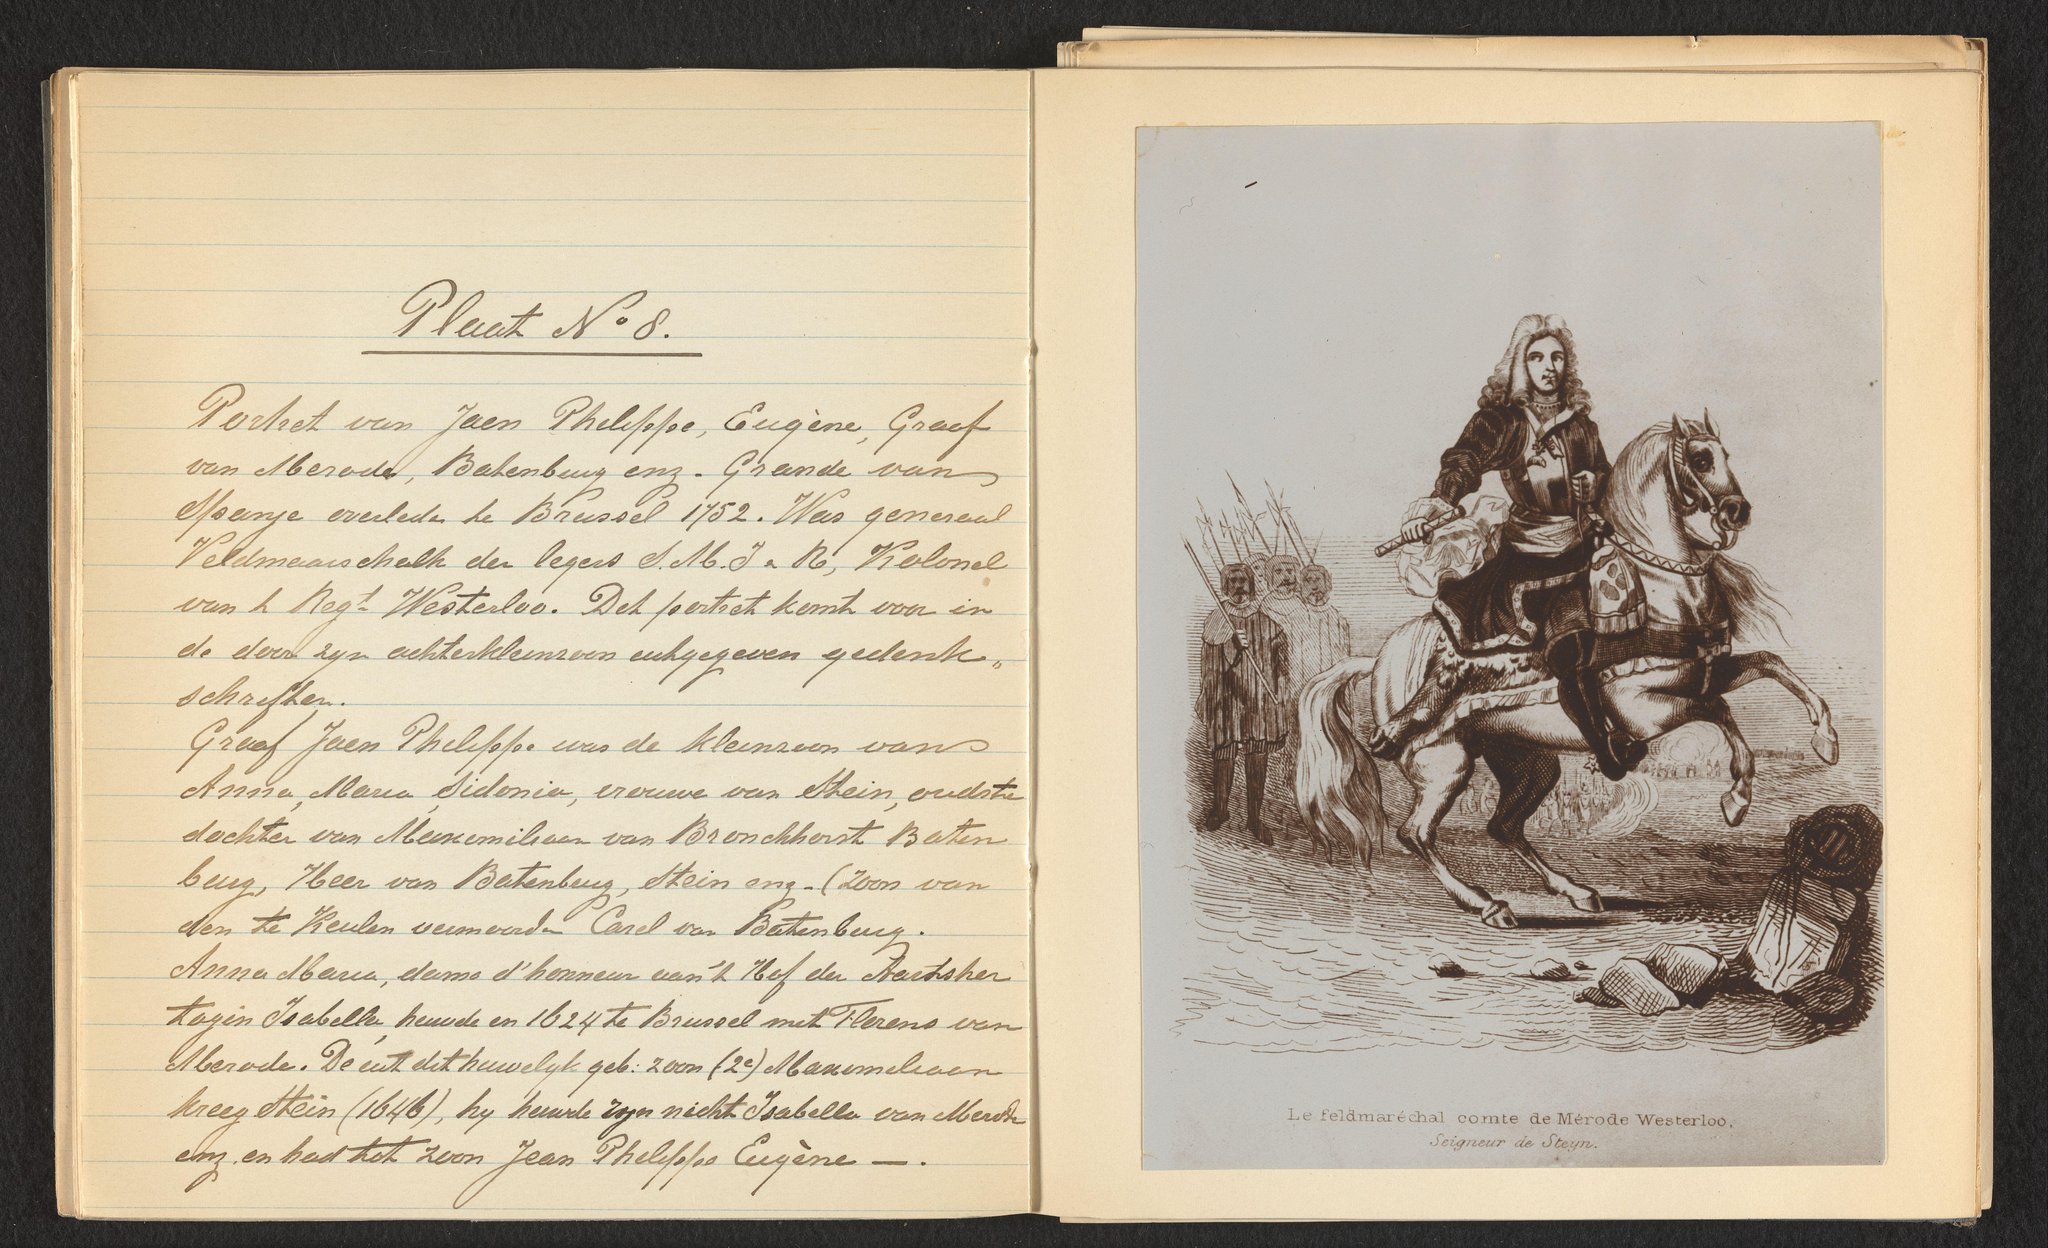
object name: photograph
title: Fotoreproductie van een getekend ruiterportret van Jan Filips Eugeen van Merode als veldmaarschalk, door Jacob van Schuppen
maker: benjamin charlé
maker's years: 1845-1925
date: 1903-1908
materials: paper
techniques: collodion silver print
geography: batenburg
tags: equestrian state-portrait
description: Foto op tweeëndertigste ongenummerde pagina.